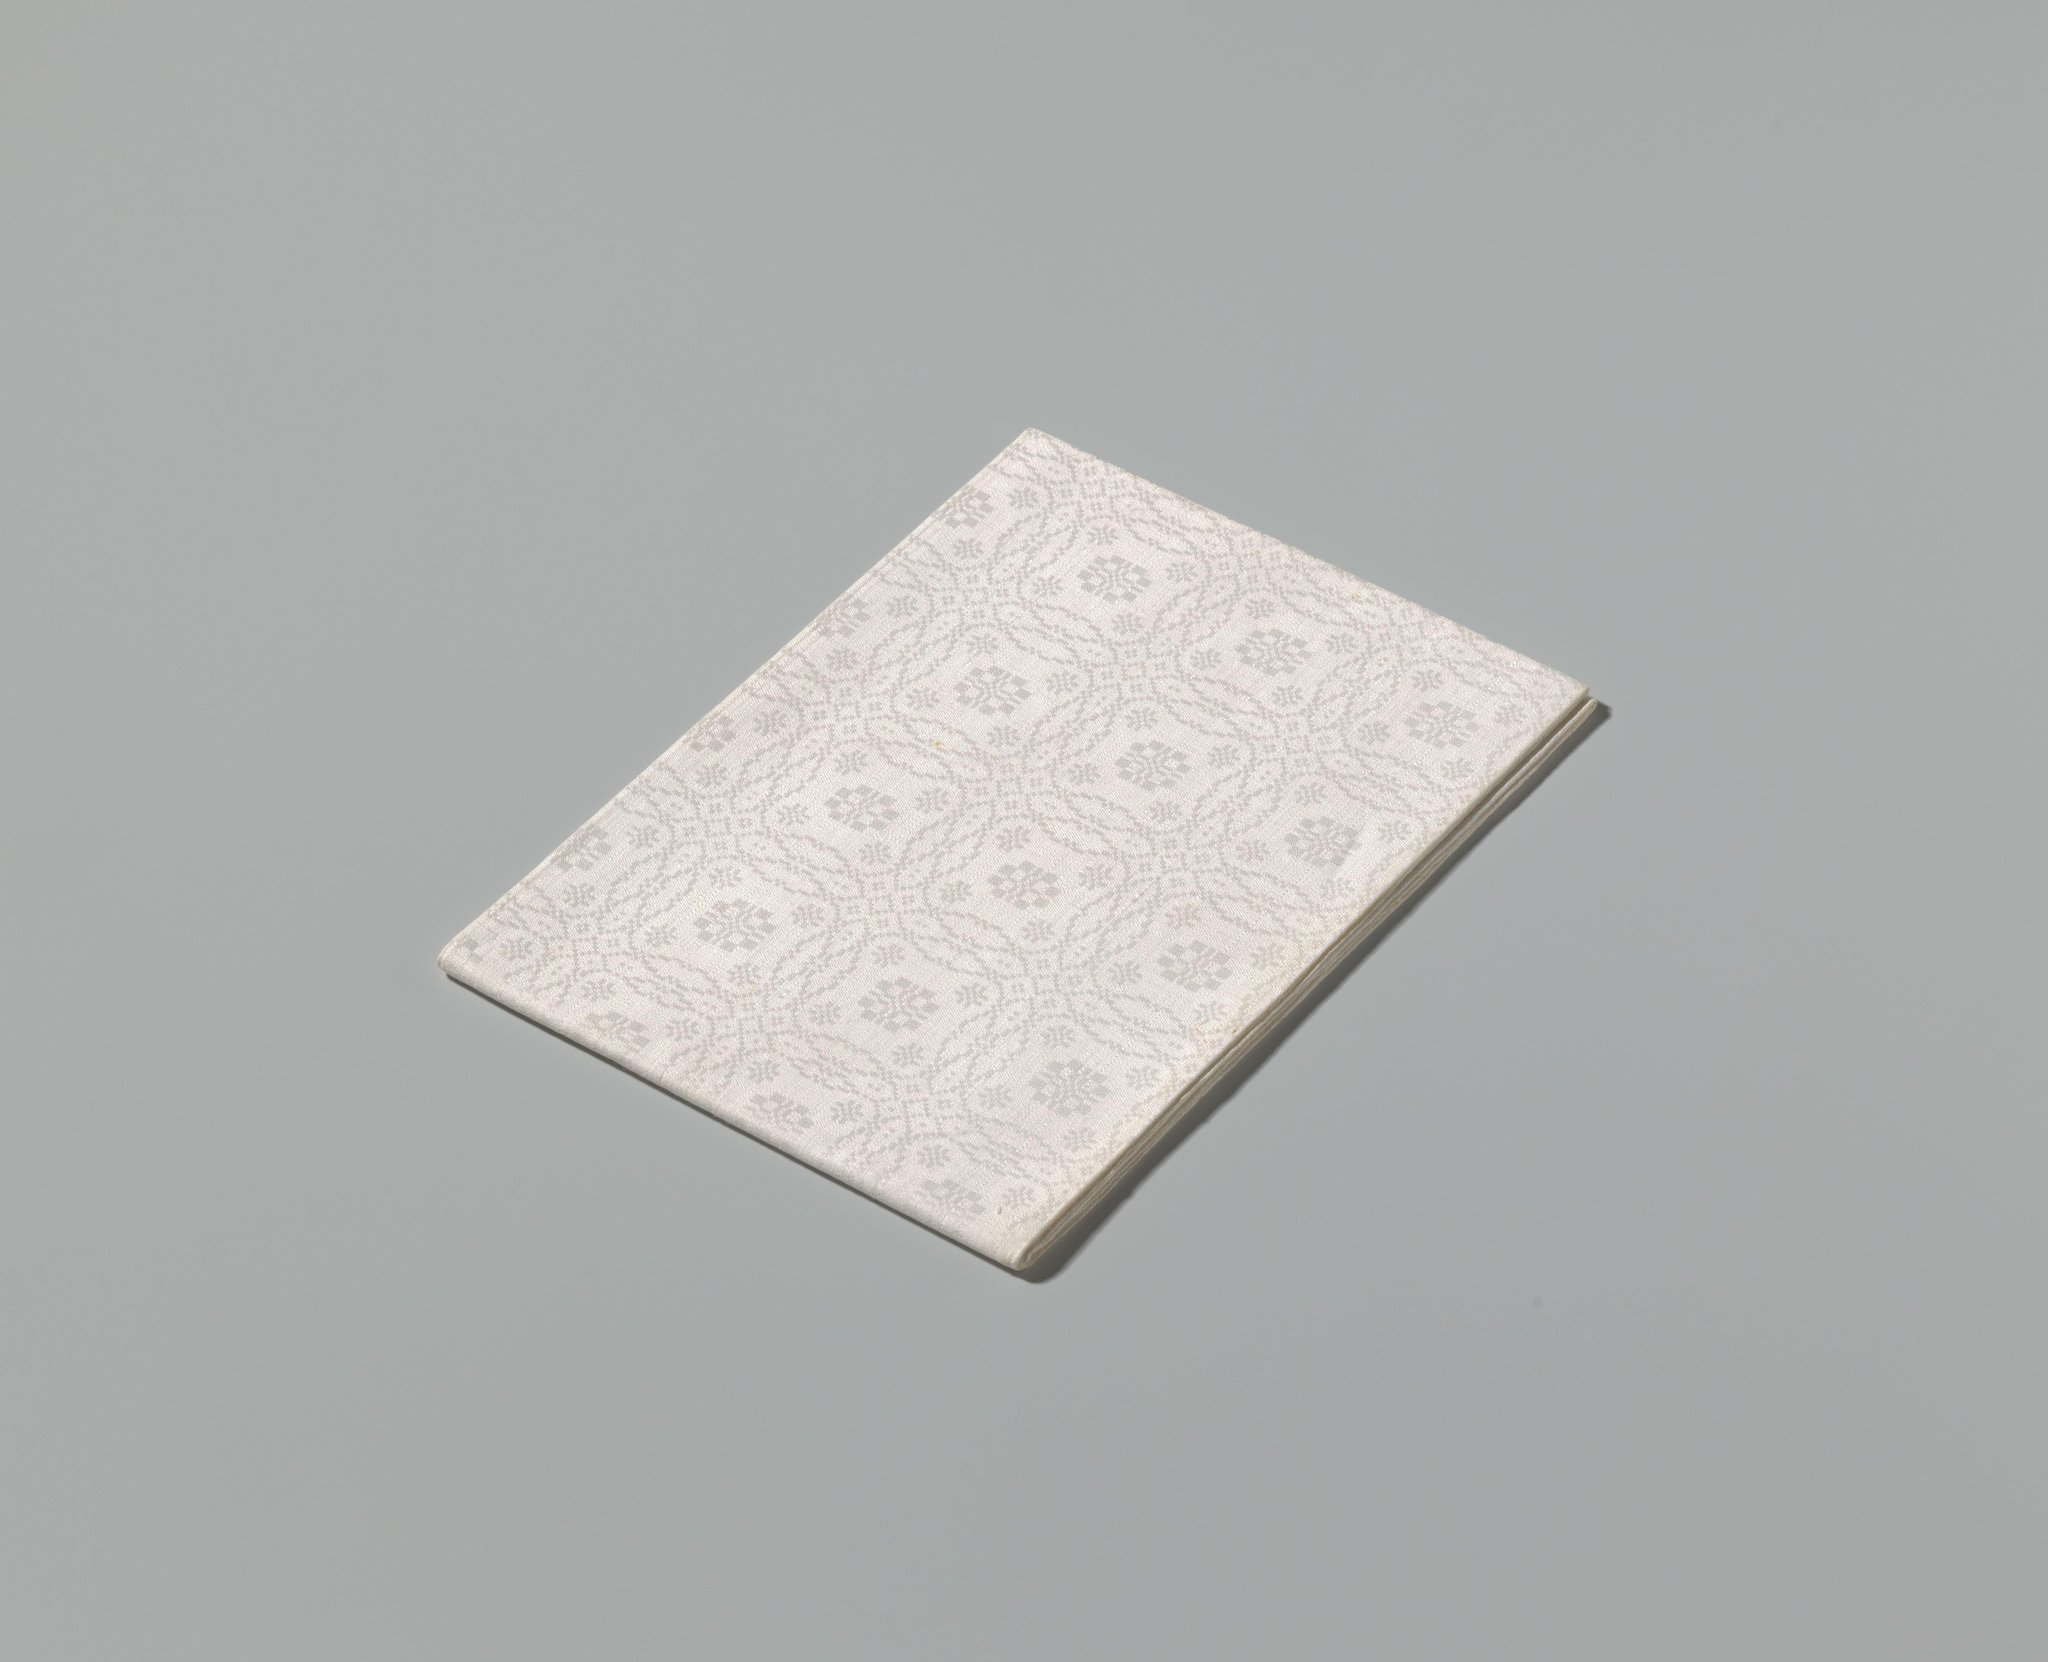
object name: napkin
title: Wit linnen pellen servet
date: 1660-1700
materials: linen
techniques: peeled fabric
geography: northern netherlands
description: Wit linnen pellen servet, gemerkt PG 24 en HW 23.